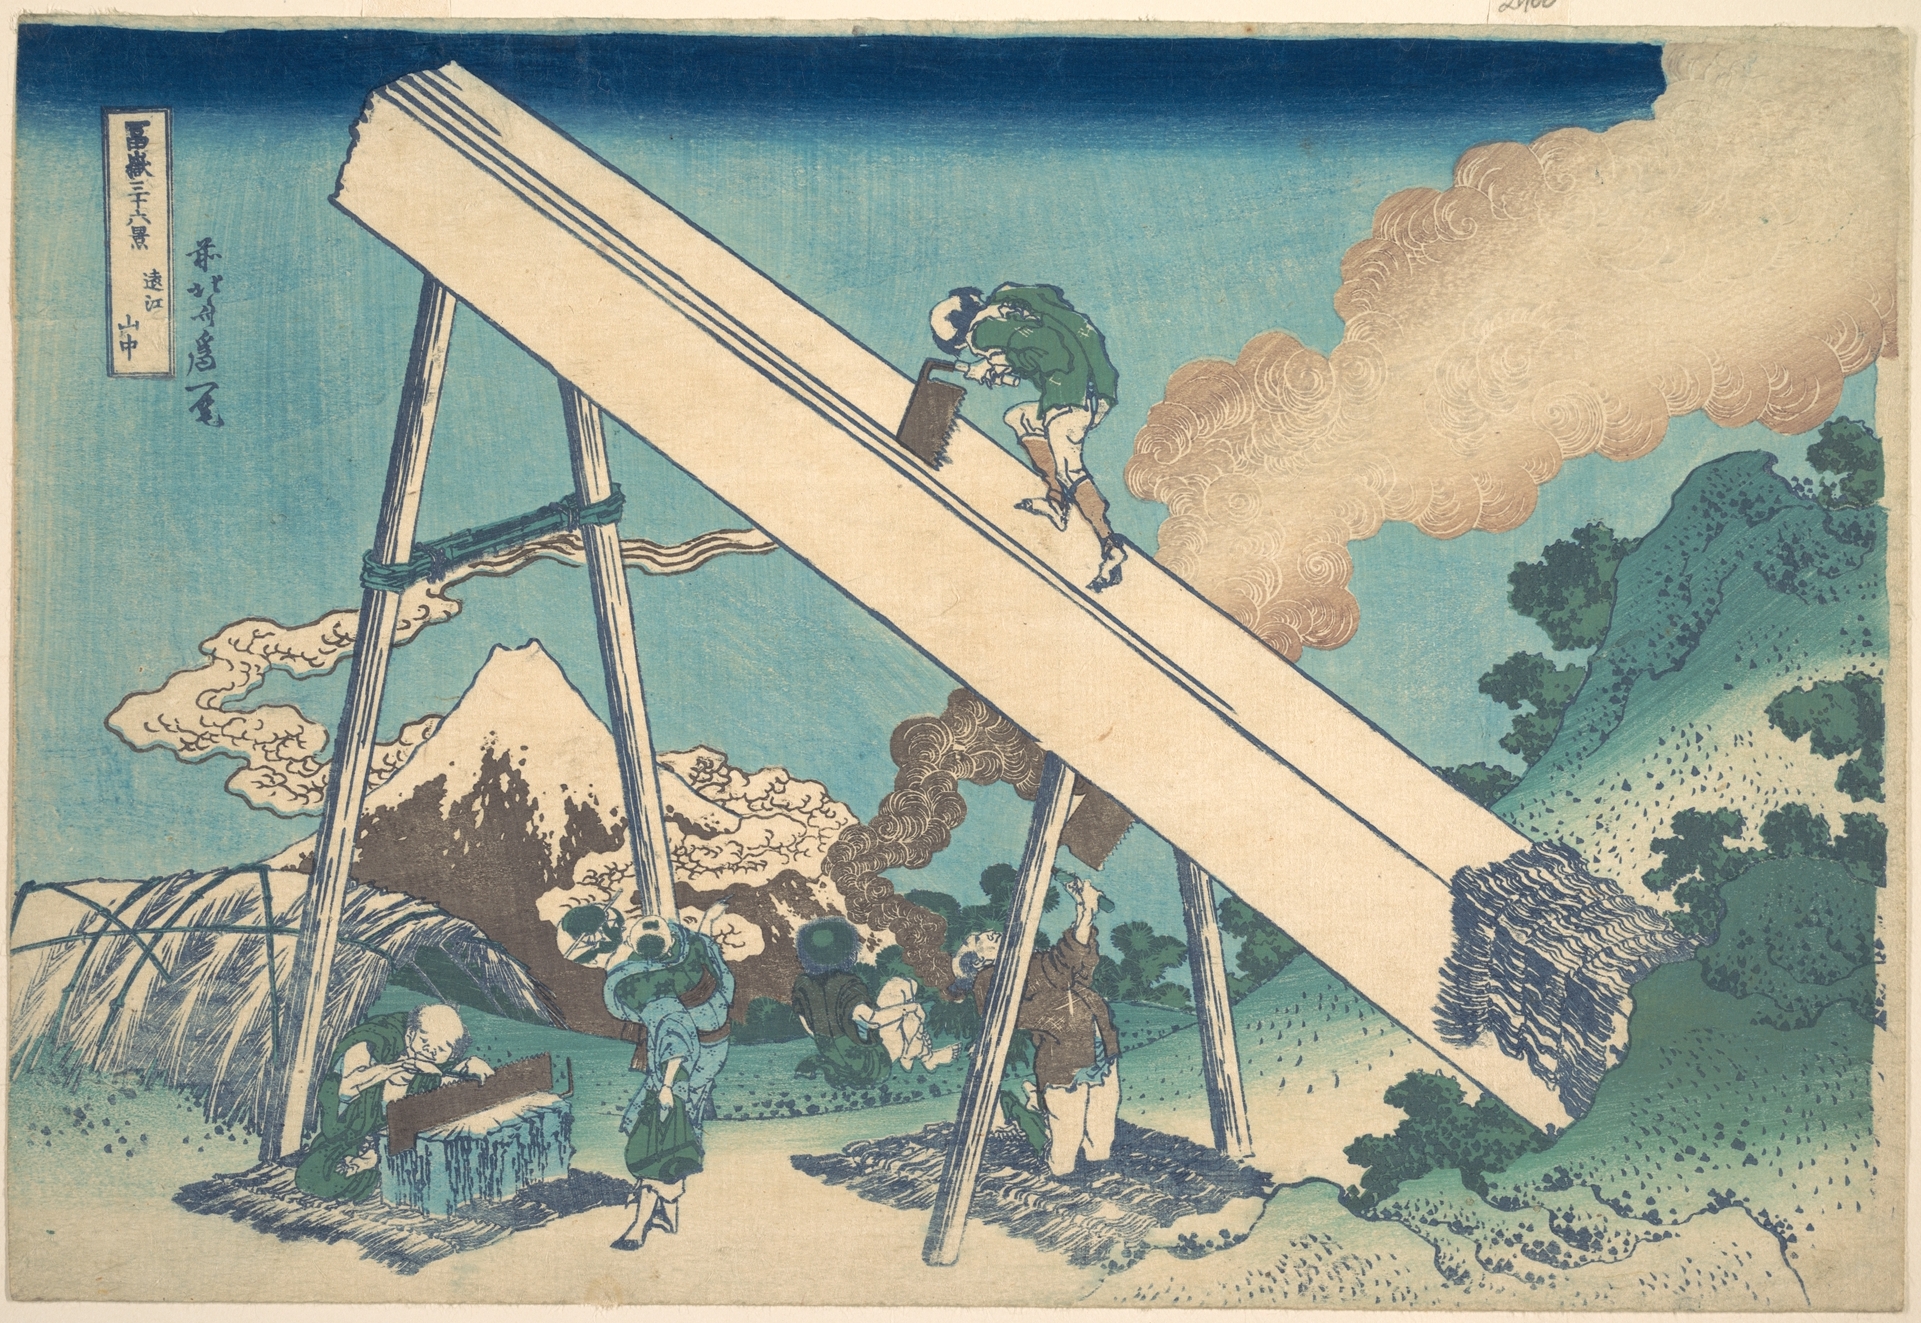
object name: woodblock print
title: In the Mountains of Tōtomi Province (Tōtomi sanchū), from the series Thirty-six Views of Mount Fuji (Fugaku sanjūrokkei)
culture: japanese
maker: katsushika hokusai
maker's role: artist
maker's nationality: japanese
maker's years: 1760-1849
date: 1830-1832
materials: ink, paper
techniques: woodblock print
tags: human figures,mountains,working